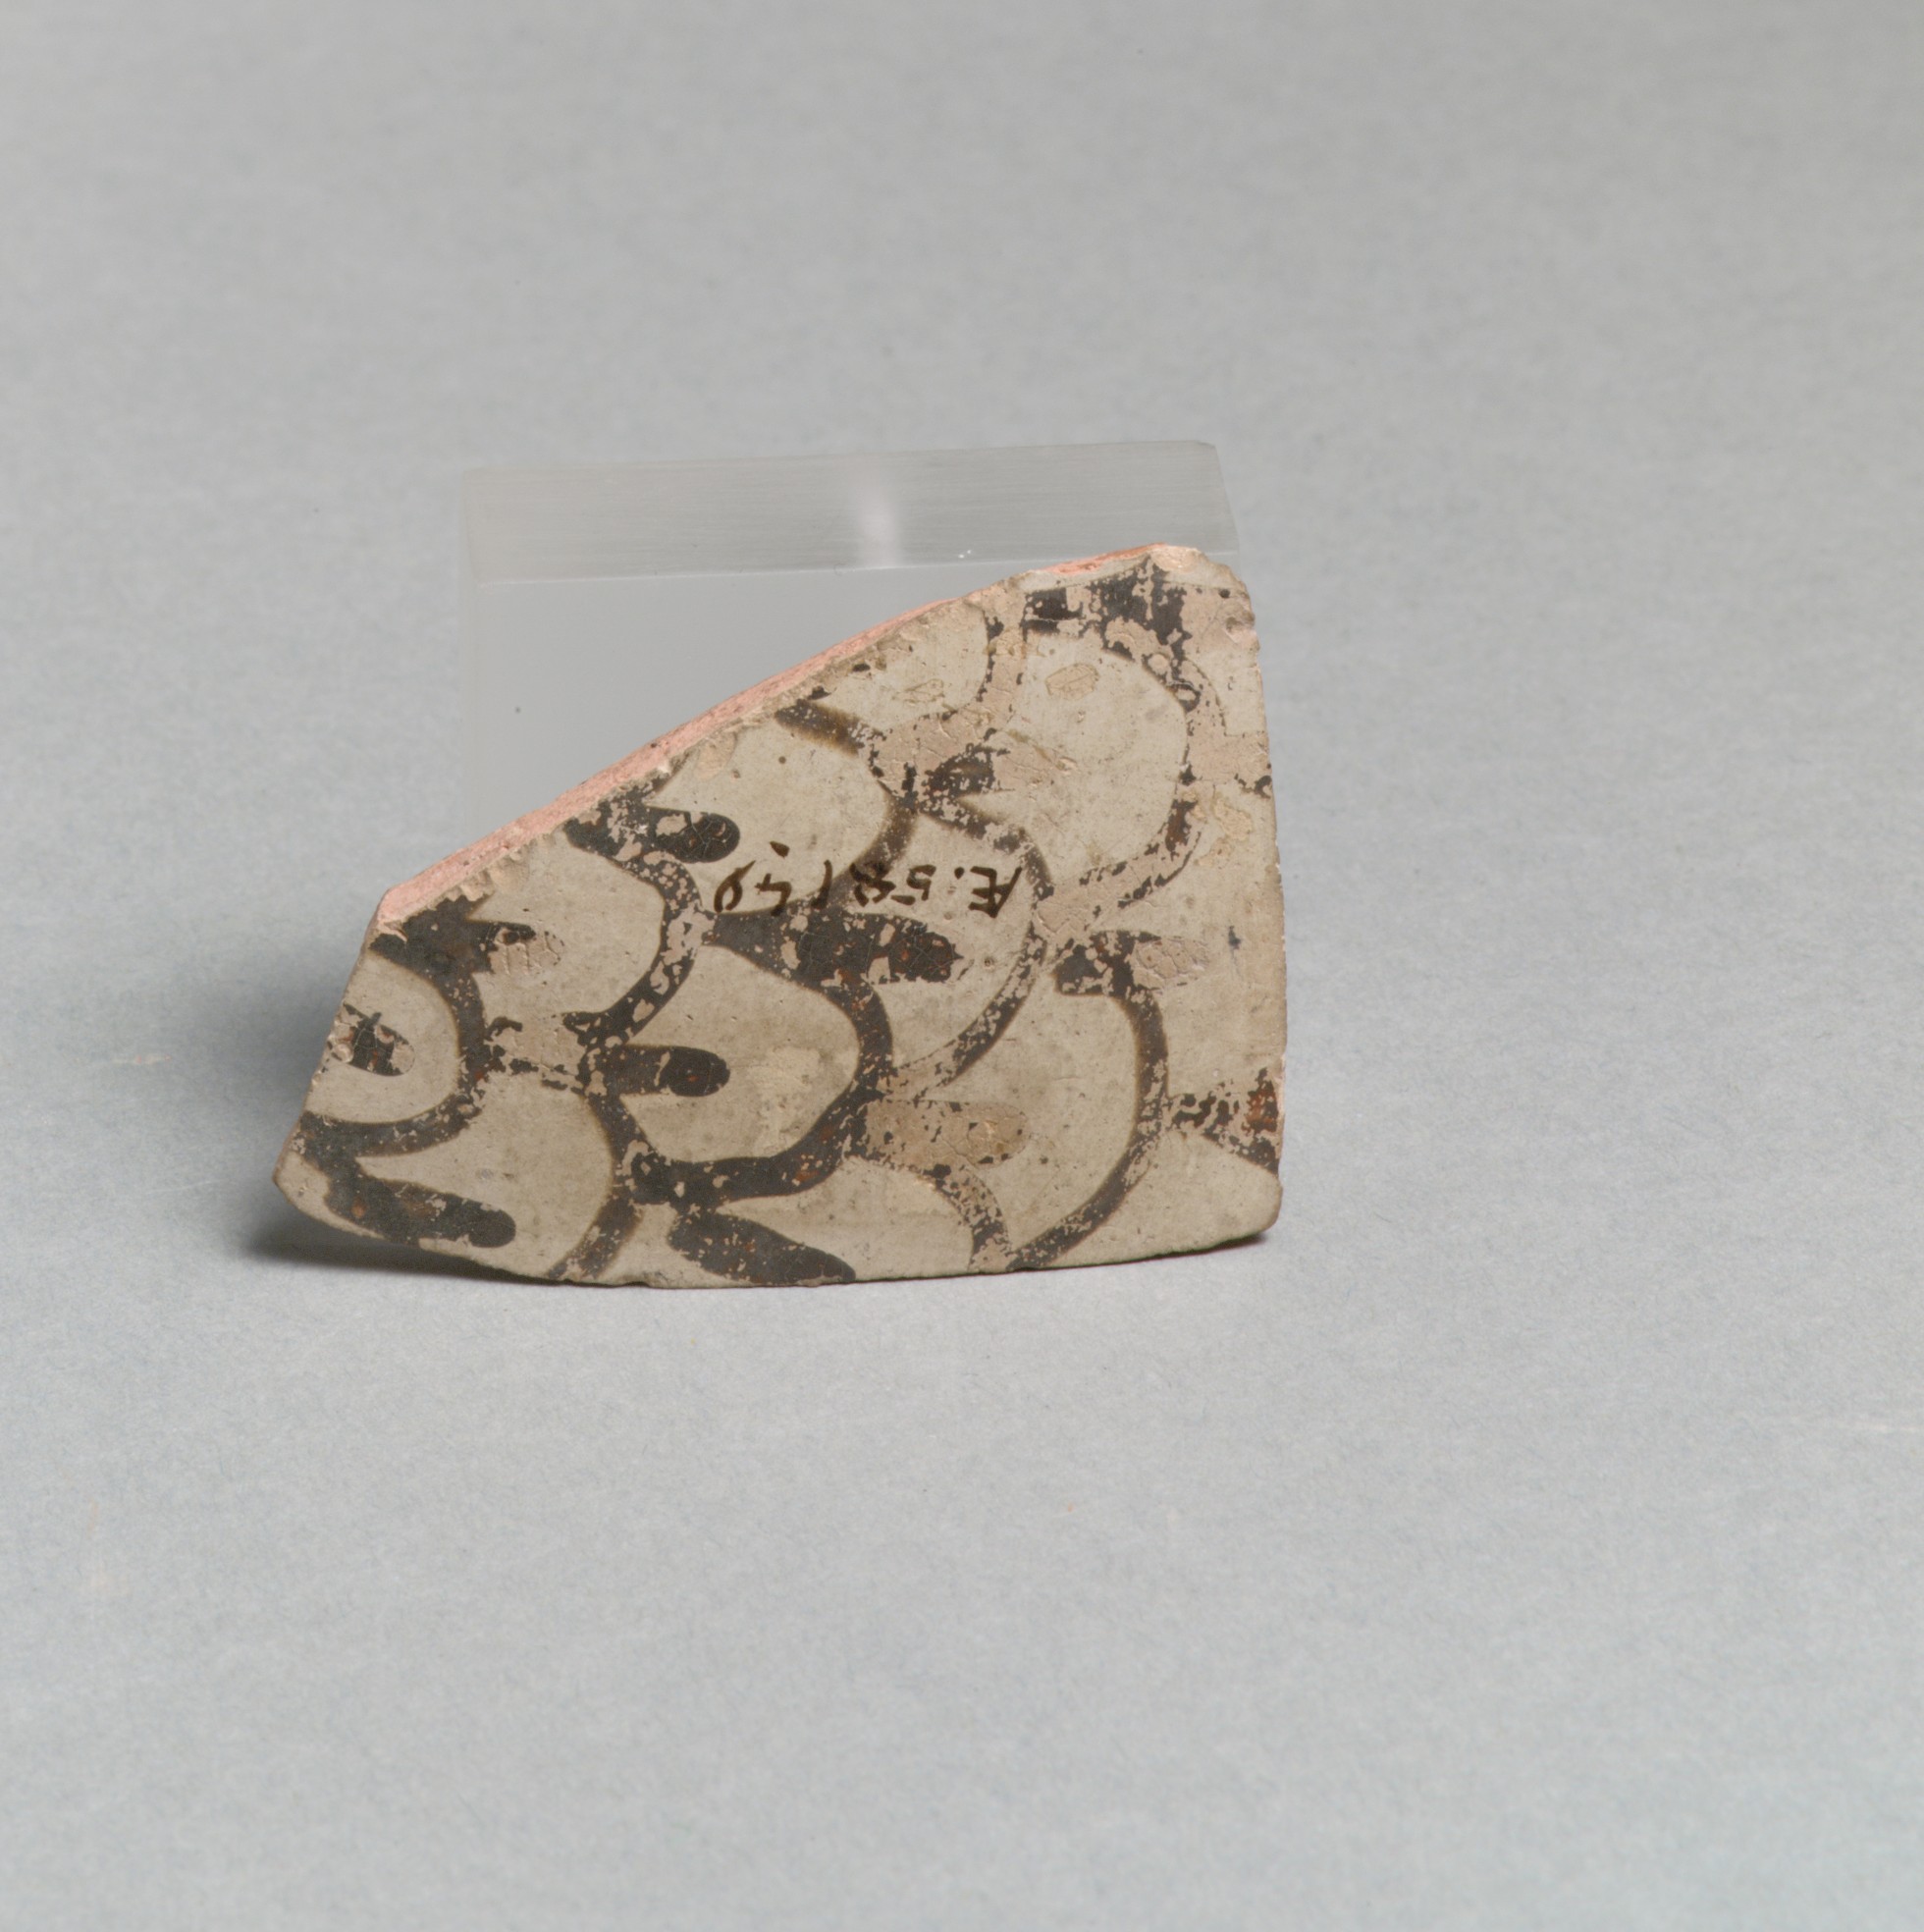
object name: vase fragment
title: Terracotta vessel fragment with scale pattern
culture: minoan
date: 1450-1400 BCE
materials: terracotta